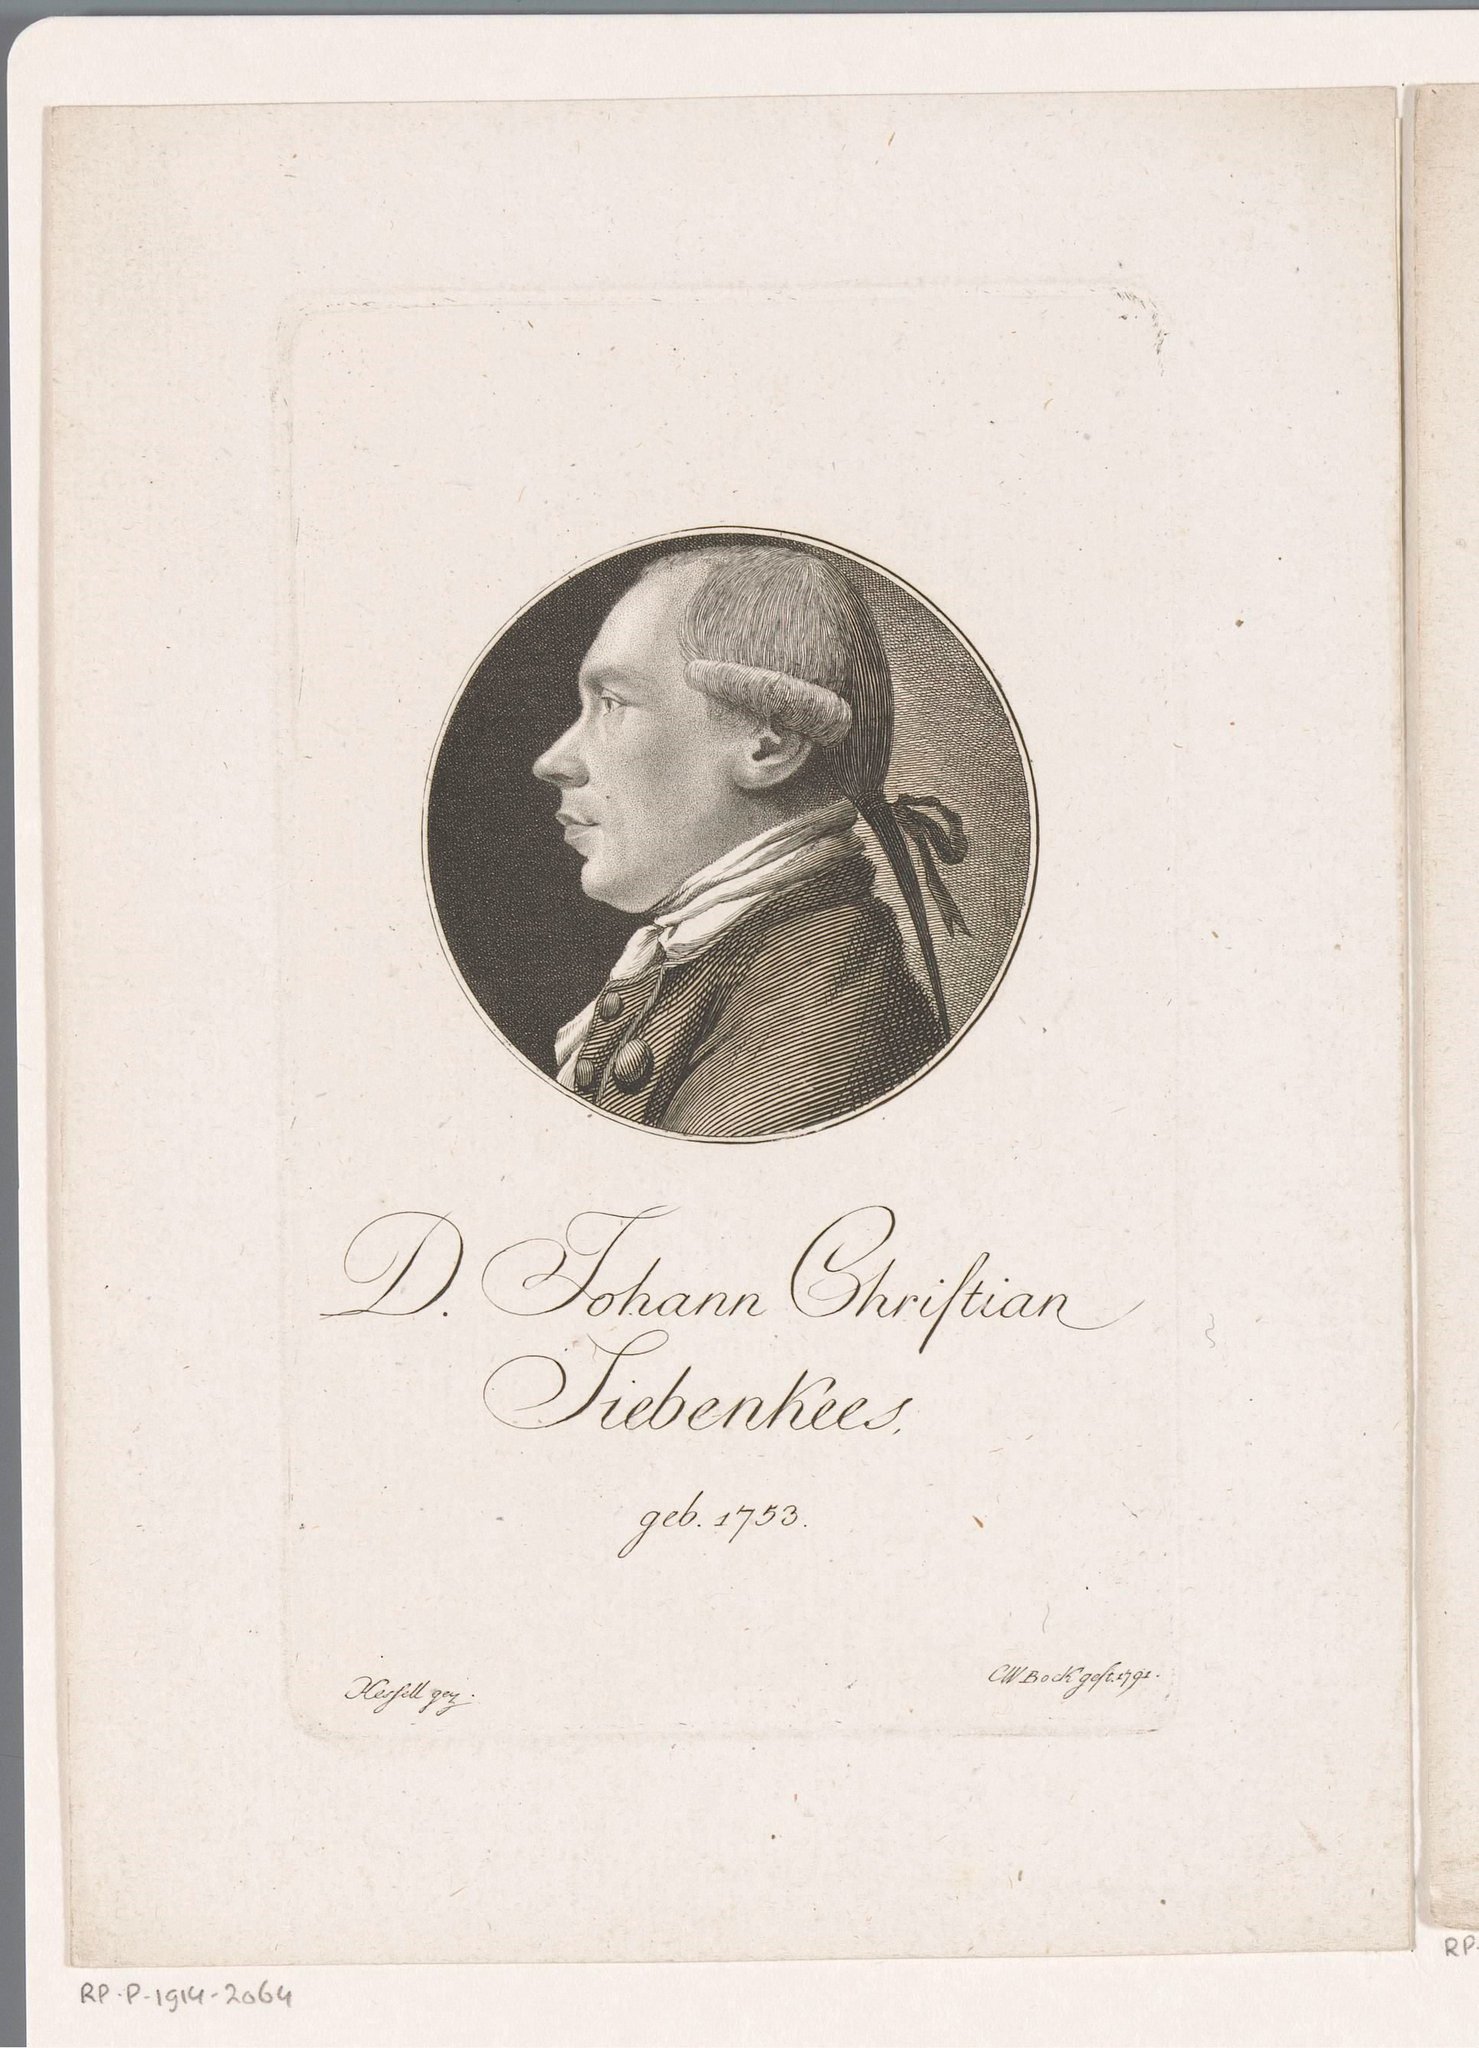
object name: print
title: Portret van Johann Christian Siebenkees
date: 1791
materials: paper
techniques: engraving, etching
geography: nuremberg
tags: historical persons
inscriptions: collector's mark: Lugt 2228